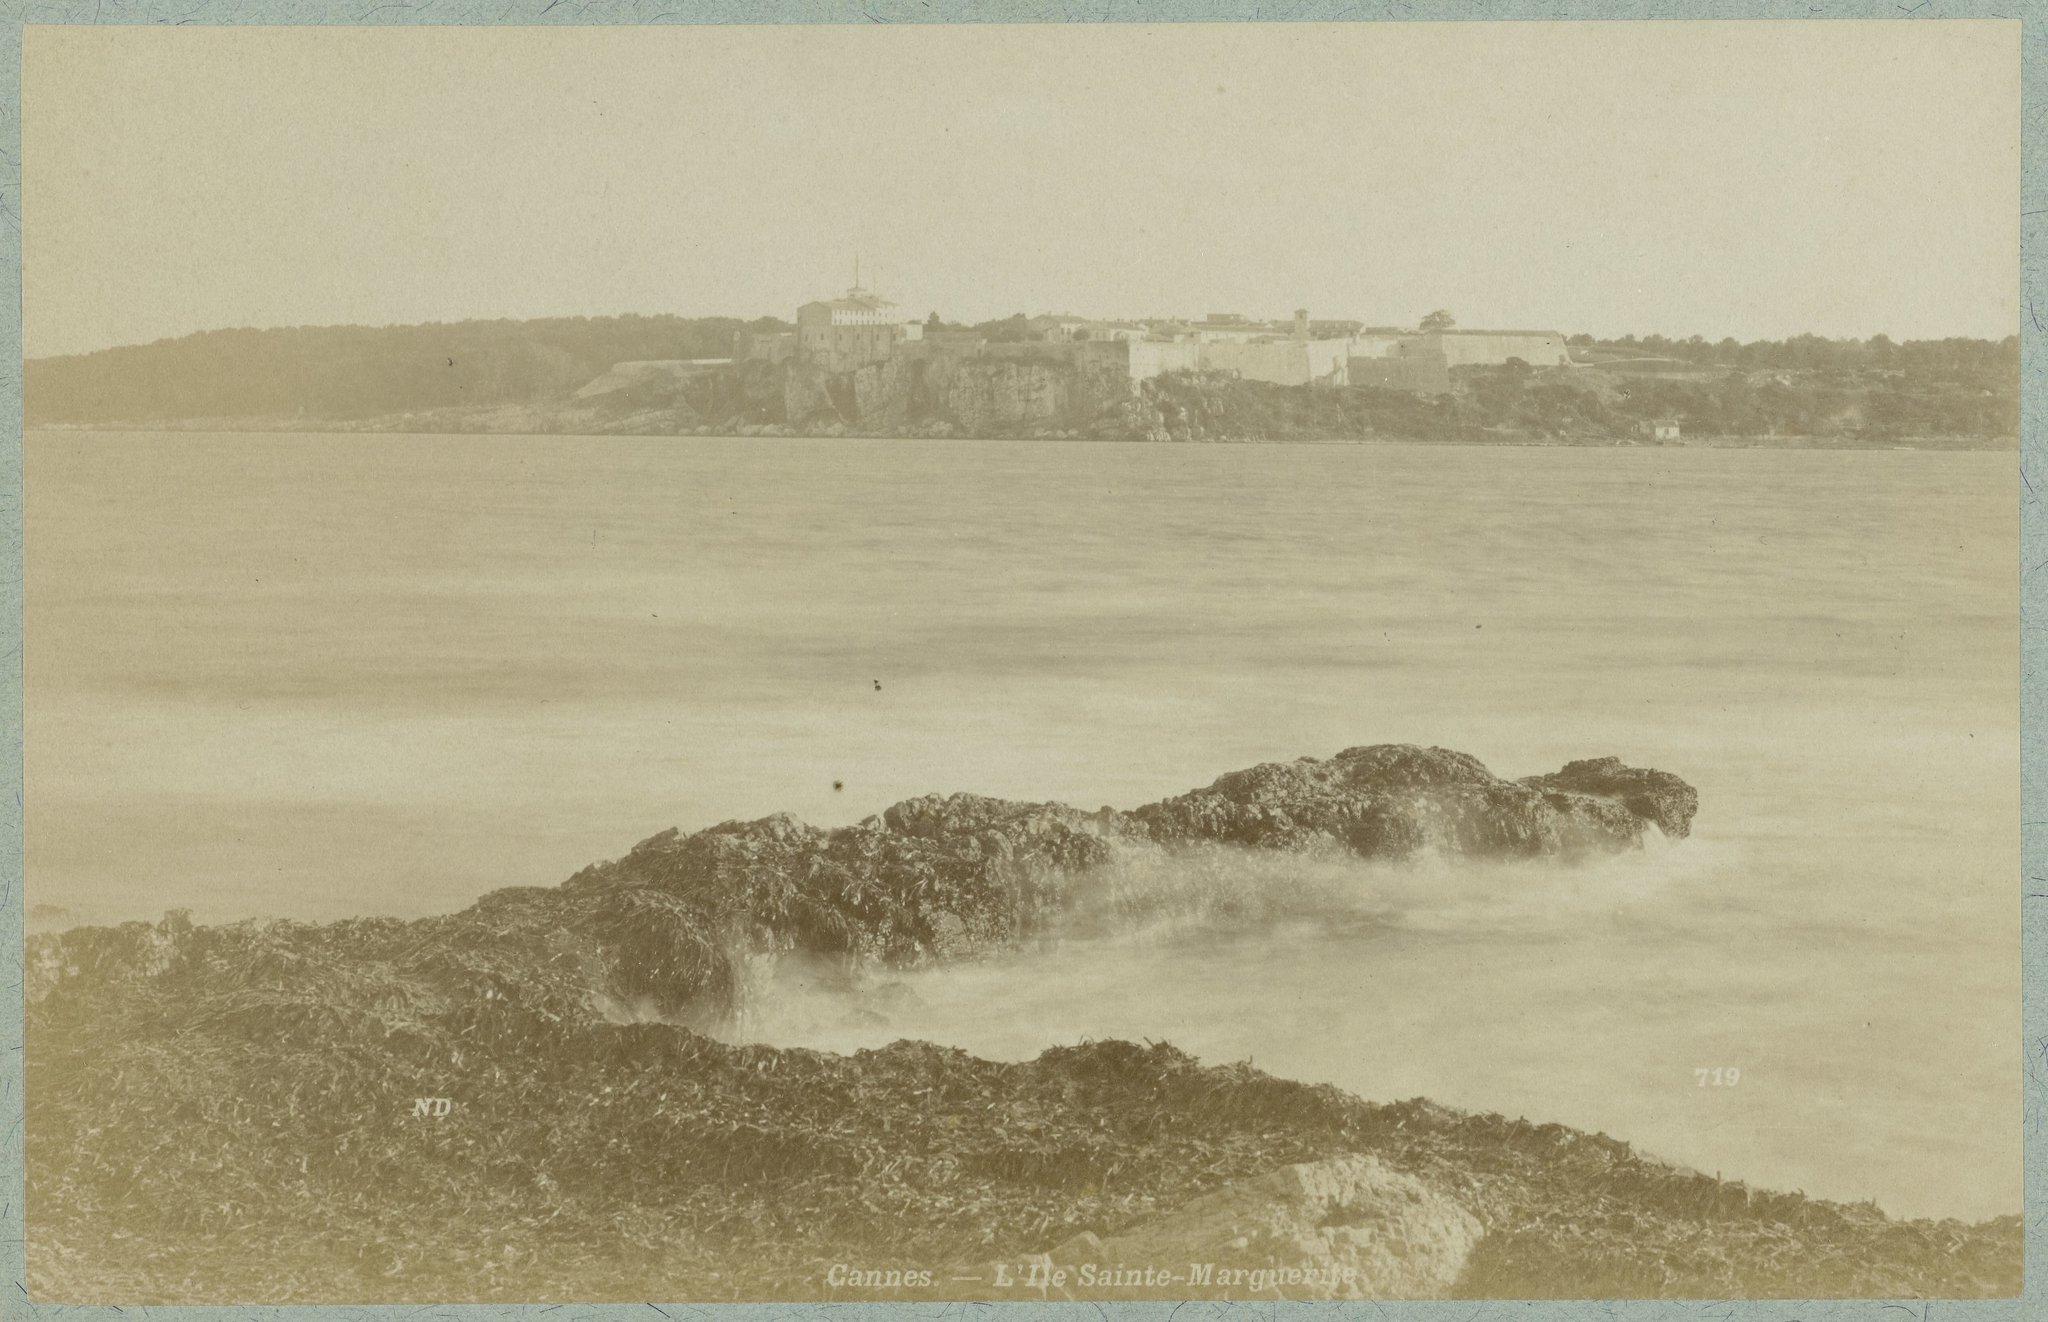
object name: photograph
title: Cannes. - L'Ile Sainte-Marguerite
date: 1863-1891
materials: cardboard, paper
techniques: albumen print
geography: cannes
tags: island, rocky coast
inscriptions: collector's mark: ‘Vosmaer’, inscription: ‘ND/ 719/ Cannes. - L'Ile Sainte-Marguerite’